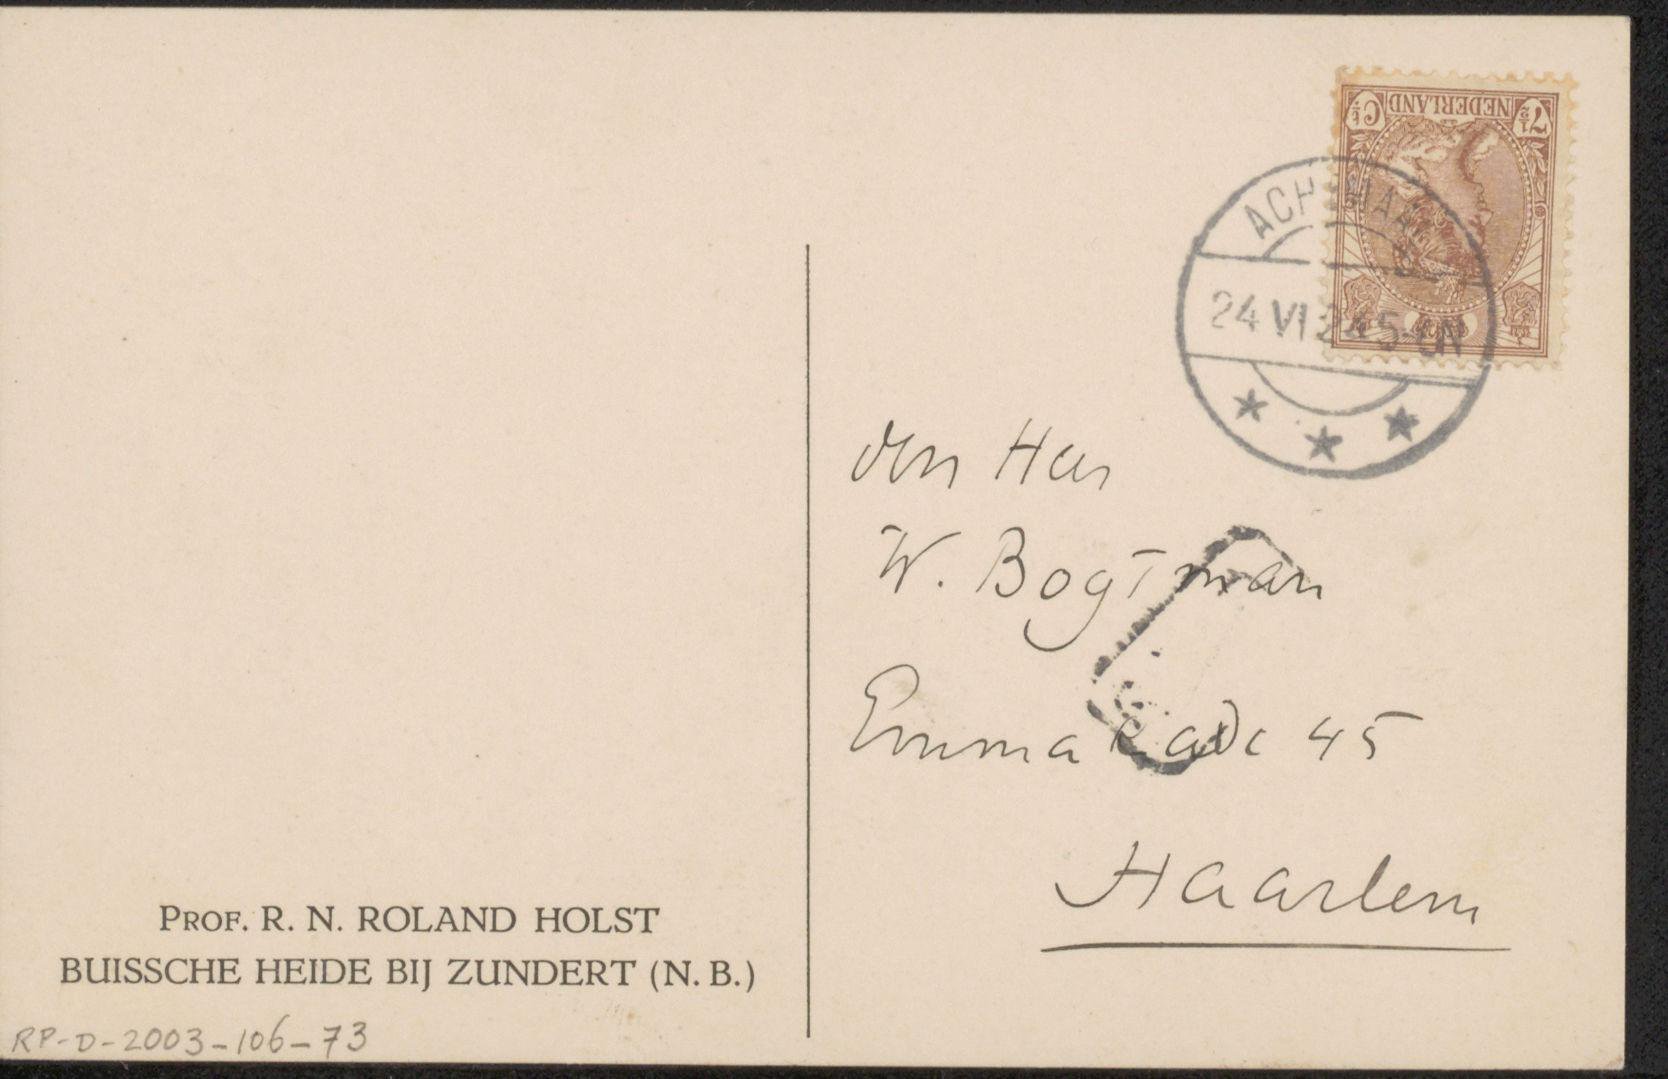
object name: postcard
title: Briefkaart aan Willem Bogtman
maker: richard nicolaüs roland holst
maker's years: 1868-1938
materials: cardboard, ink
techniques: pen, writing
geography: achtmaal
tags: haarlem, willem bogtman